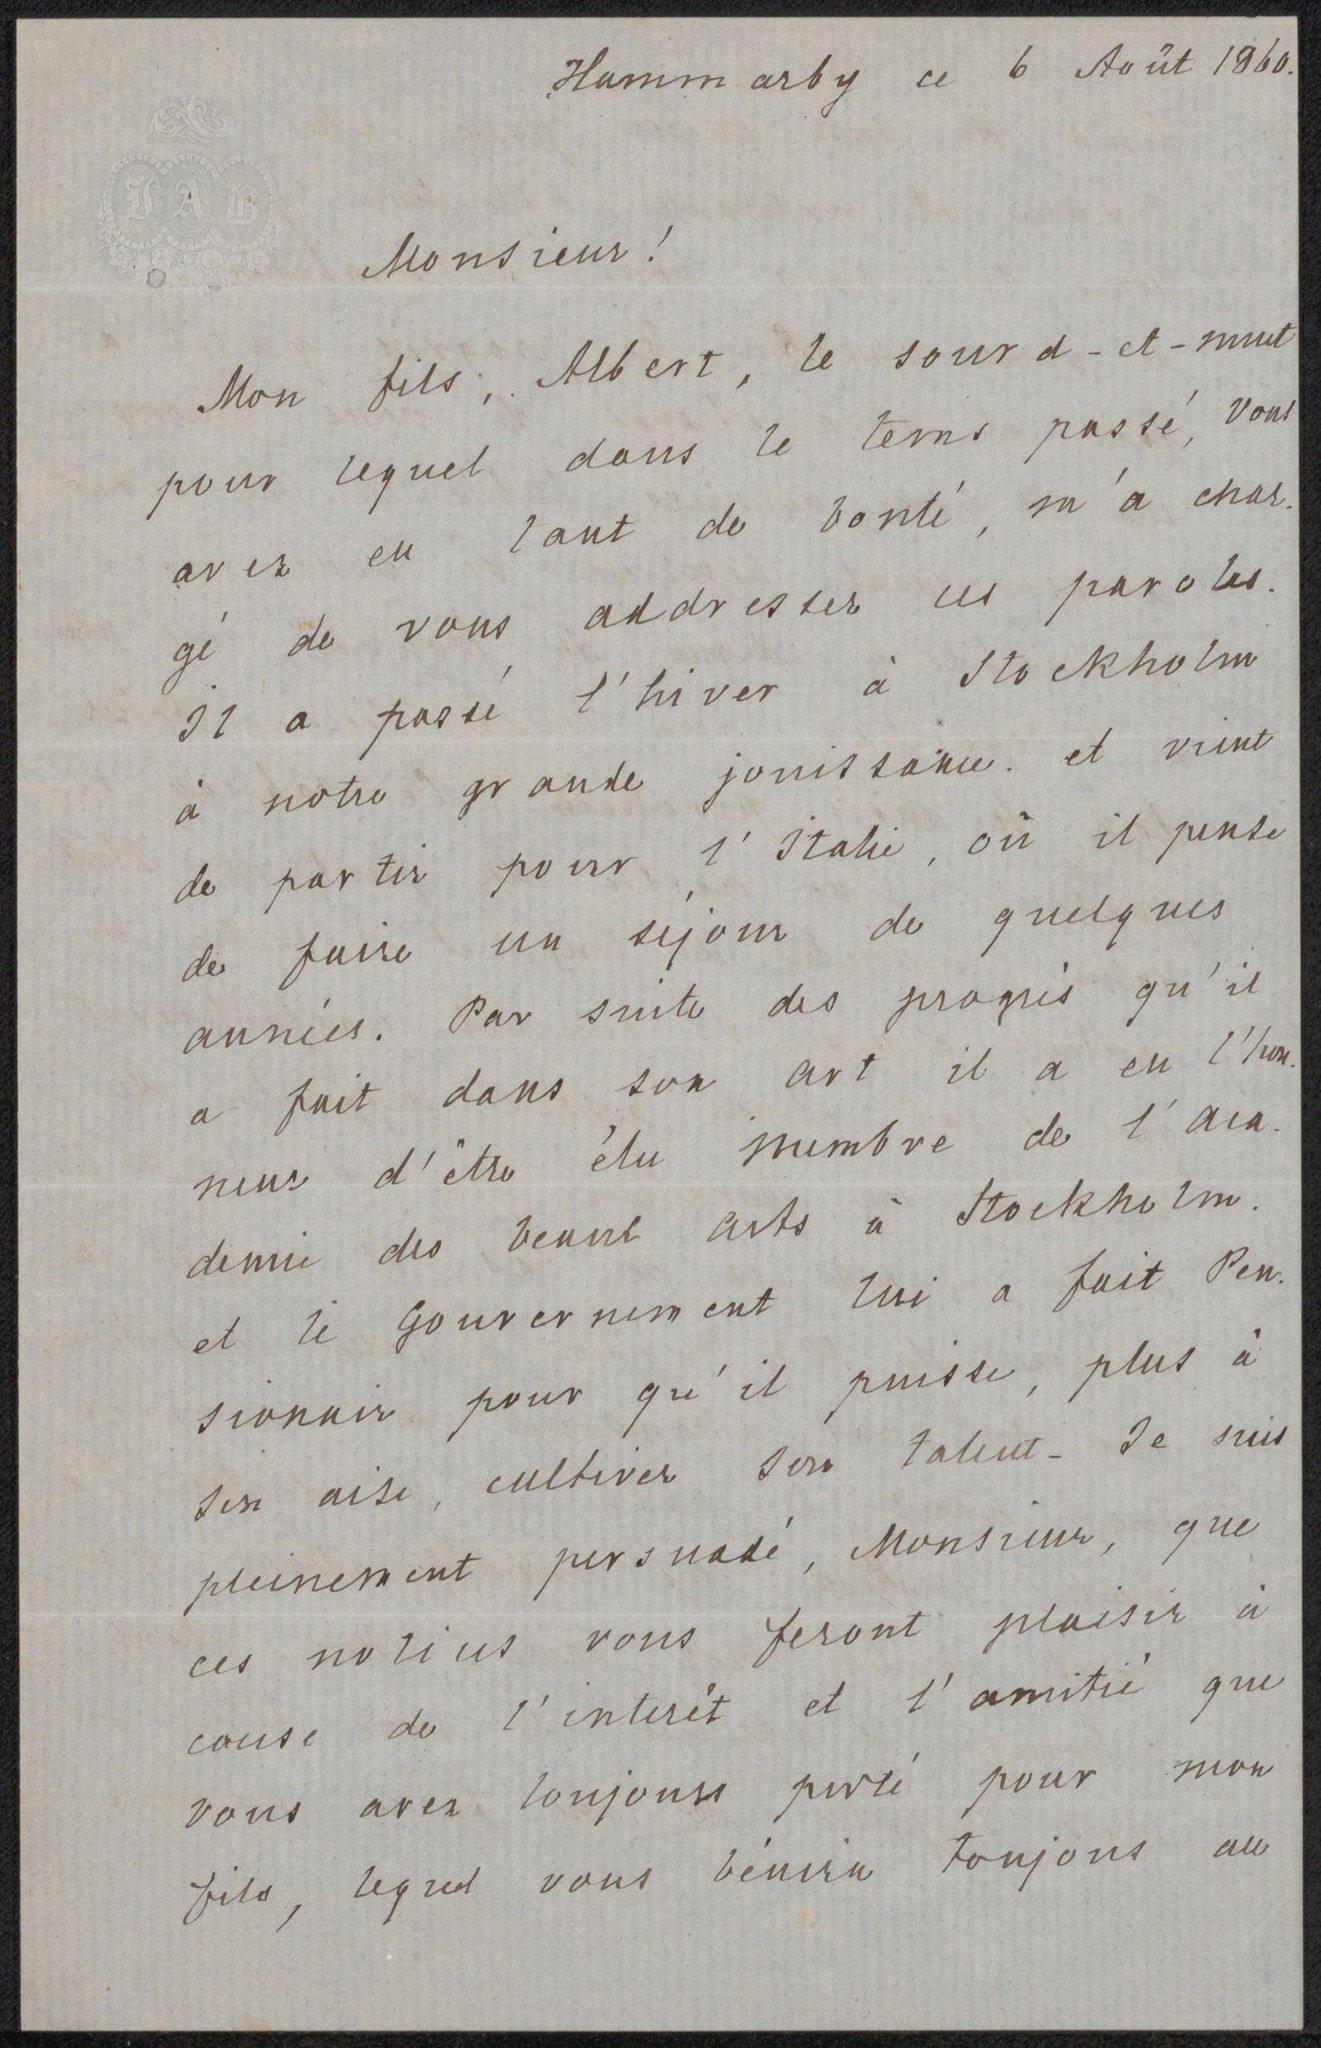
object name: letter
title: Brief aan Ary Johannes Lamme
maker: isak albert berg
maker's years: 1803-1886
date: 1860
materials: ink, paper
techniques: pen, writing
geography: hammarby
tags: painter, print maker, draughtsman, sculptor, ary scheffer, paris, cornelia marjolin-scheffer, ary johannes lamme, family life, travelling; tourism, education, tuition of the artist (in general), painting (including book-illumination, miniature-painting), exhibition ~ art, italy, rotterdam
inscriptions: collector's mark: Lugt 2228, initials: ‘I A B’